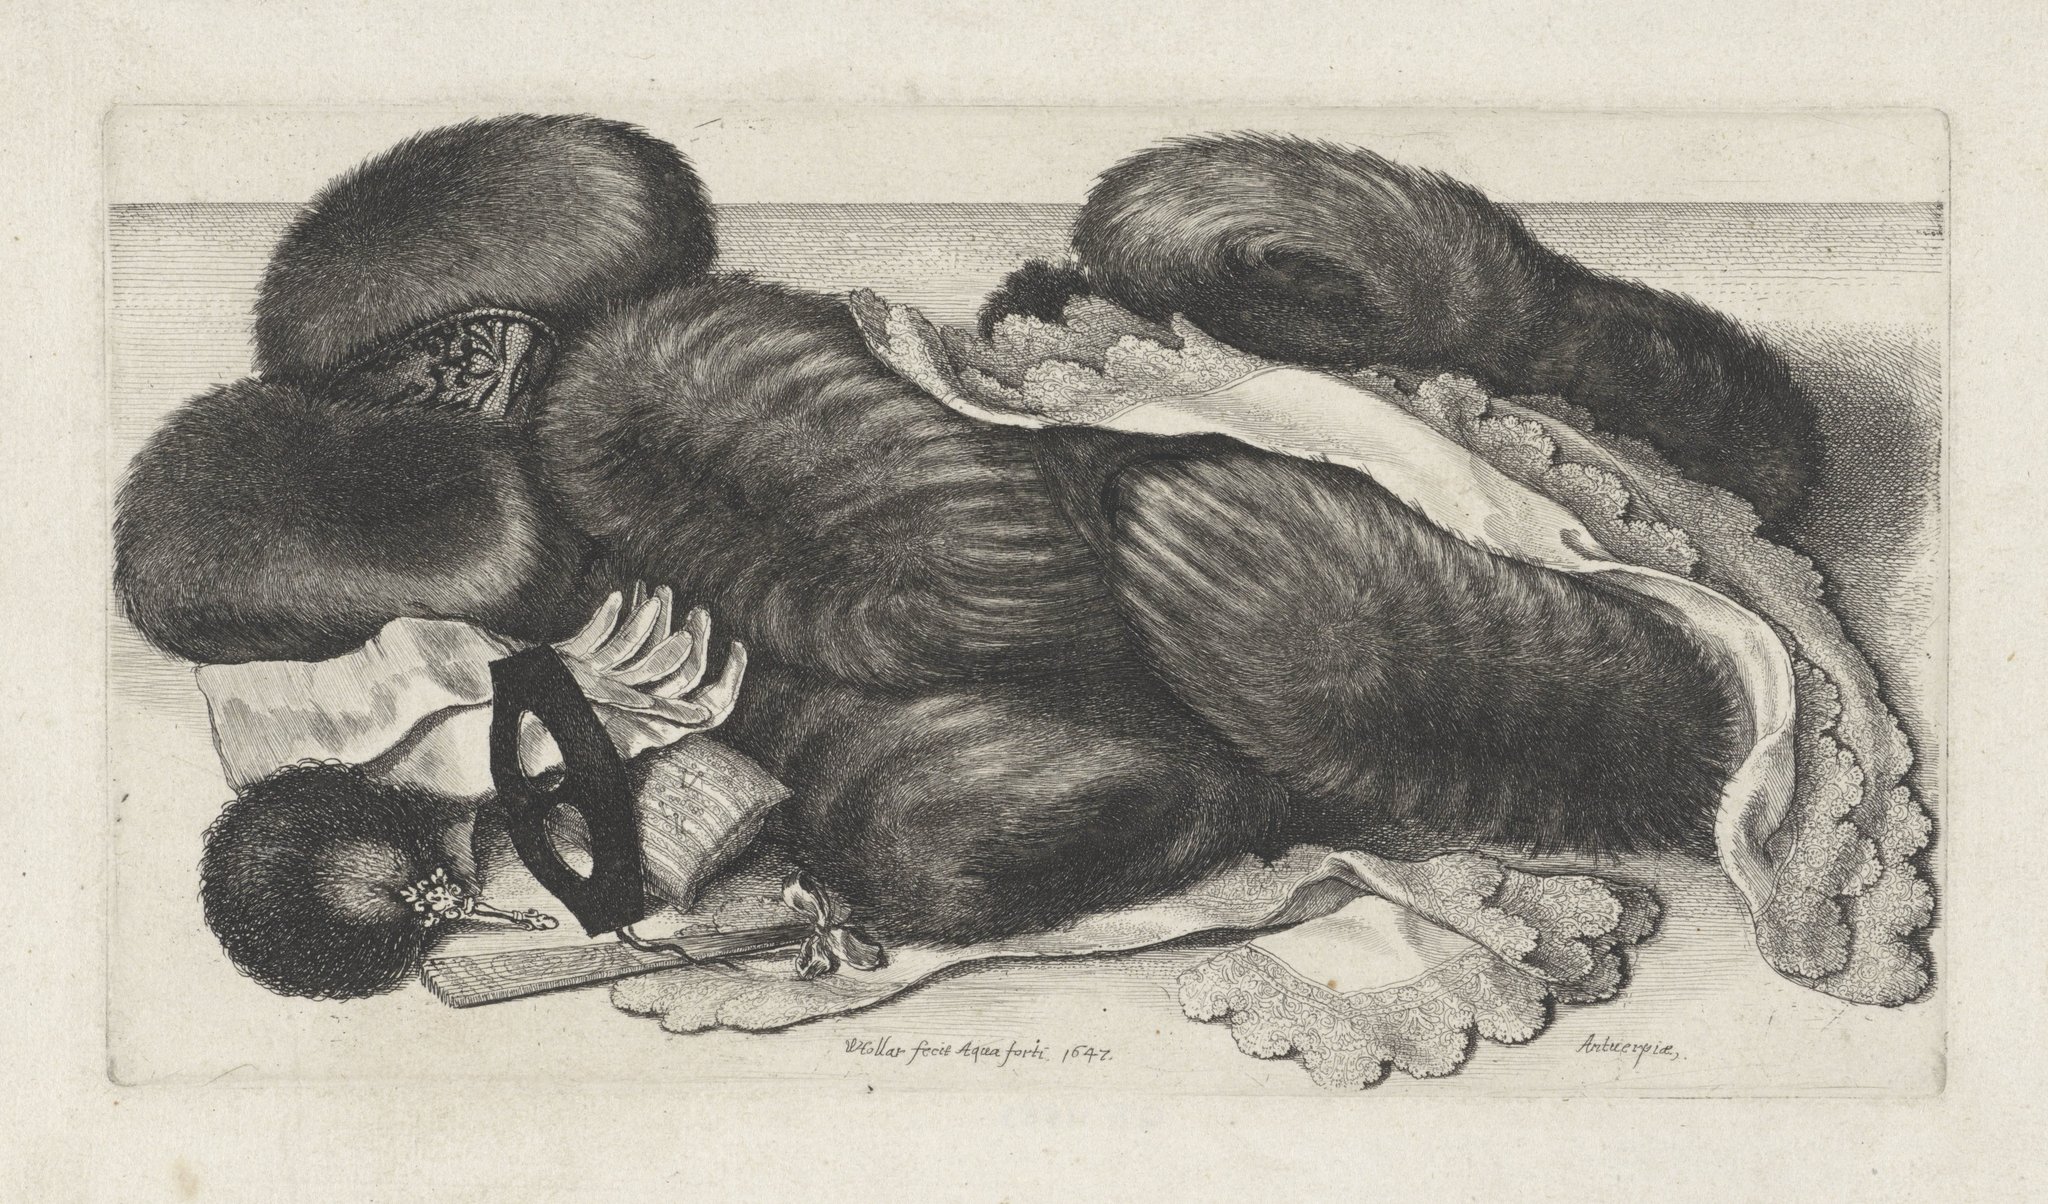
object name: print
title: Still Life with Accessories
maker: wenceslaus hollar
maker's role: draughtsman, print maker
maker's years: 1607-1677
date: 1647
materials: paper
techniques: etching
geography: antwerp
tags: handkerchief (+ women's clothes), border, ribbon, braid (+ women's clothes), neck-gear ~ clothing (neckerchief) (+ women's clothes), black velvet or satin mask, 'loup', 'cachenez' (+ women's clothes), gloves, mittens, etc. (+ women's clothes), muff (+ fur used for clothes)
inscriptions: collector's mark: Lugt 240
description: Hollar’s still lifes of muffs are true masterpieces, displaying his ability to capture the softness of fur using only a series of etched lines. Apart from muffs, this composition also includes satin gloves, lace handkerchiefs, a velvet mask, and a feather fan – a variety of textures and materials that show off his skills as an etcher. Hollar was the first printmaker to use women’s accessories as the basis for still life.